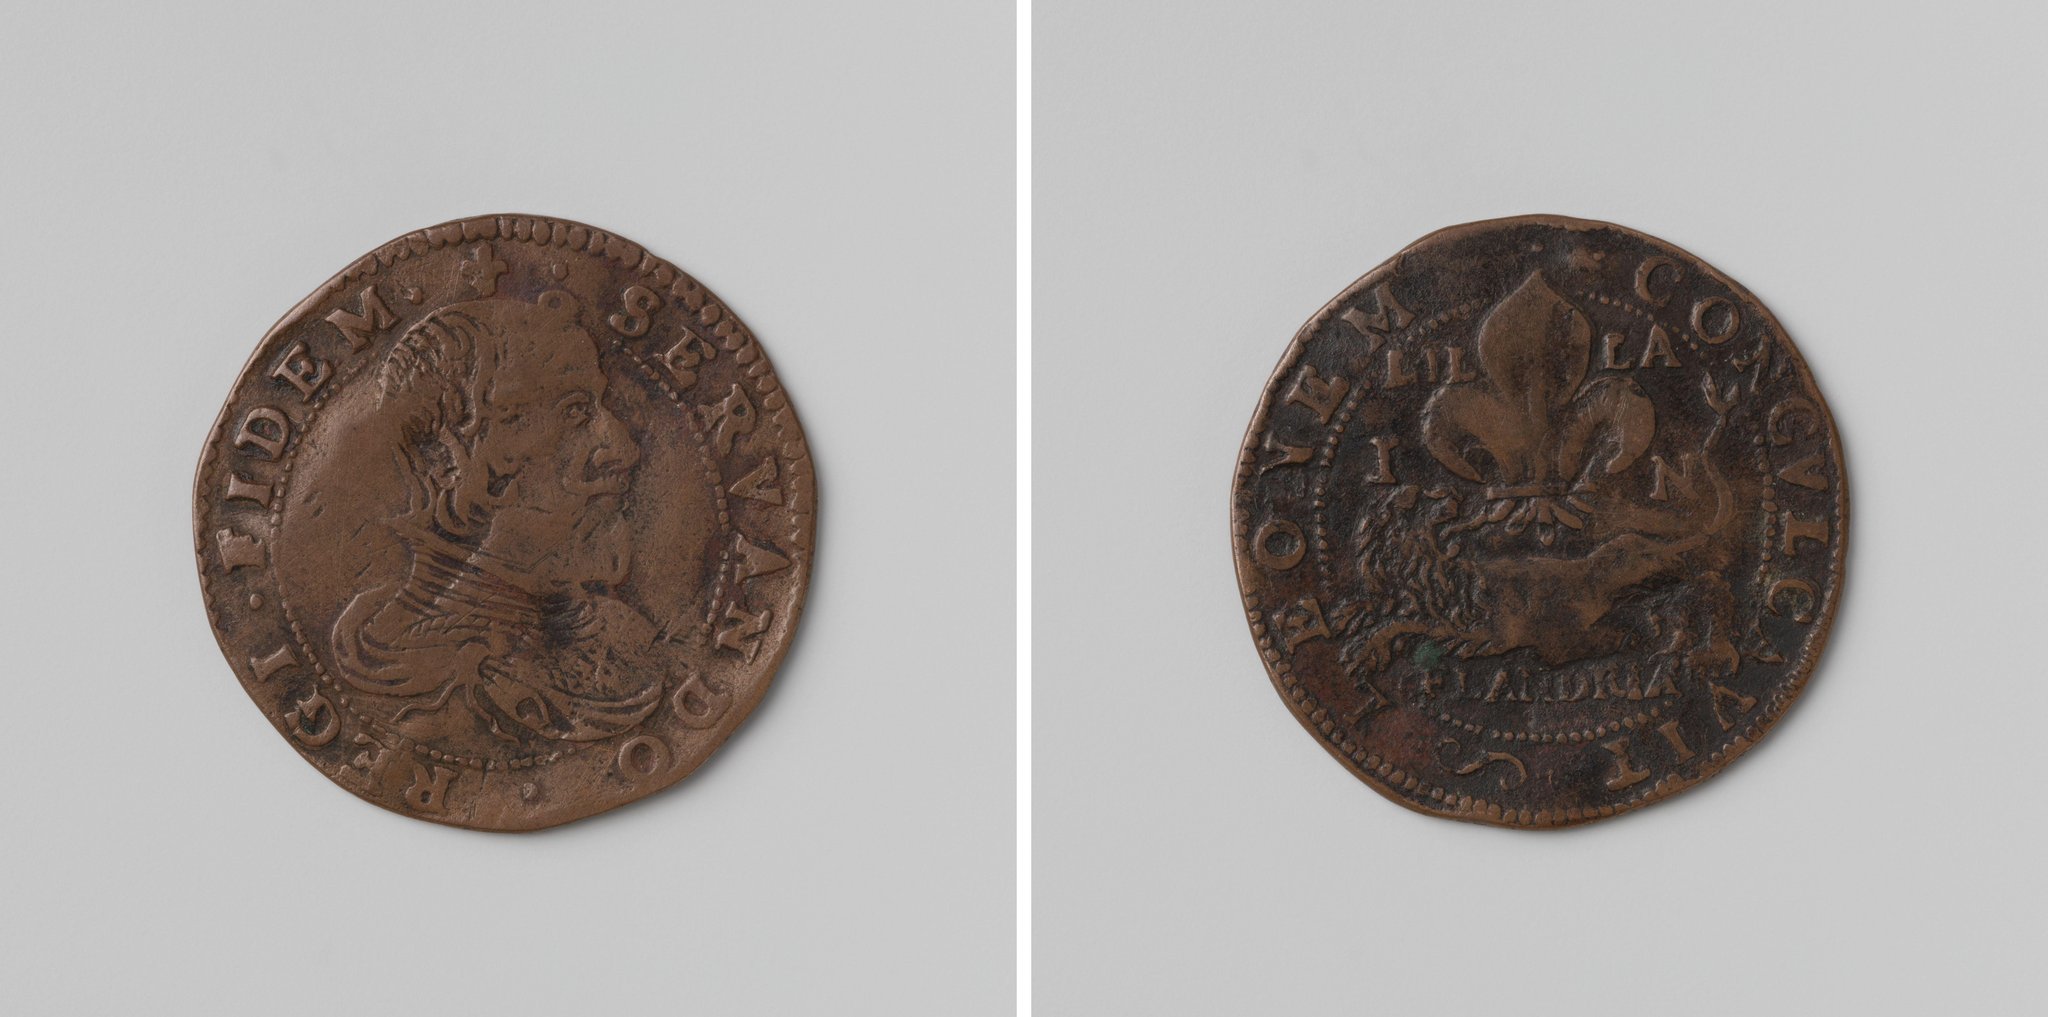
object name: jeton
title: Filips IV, koning van Spanje, rekenpenning van Vlaanderen [?]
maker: Anonymous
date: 1660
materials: copper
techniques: striking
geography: belgium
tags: filips iv (koning van spanje)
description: Koperen penning. Voorzijde: borststuk man binnen omschrift. Keerzijde: omkijkende leeuw onder grote lelie tussen opschriften binnen omschrift